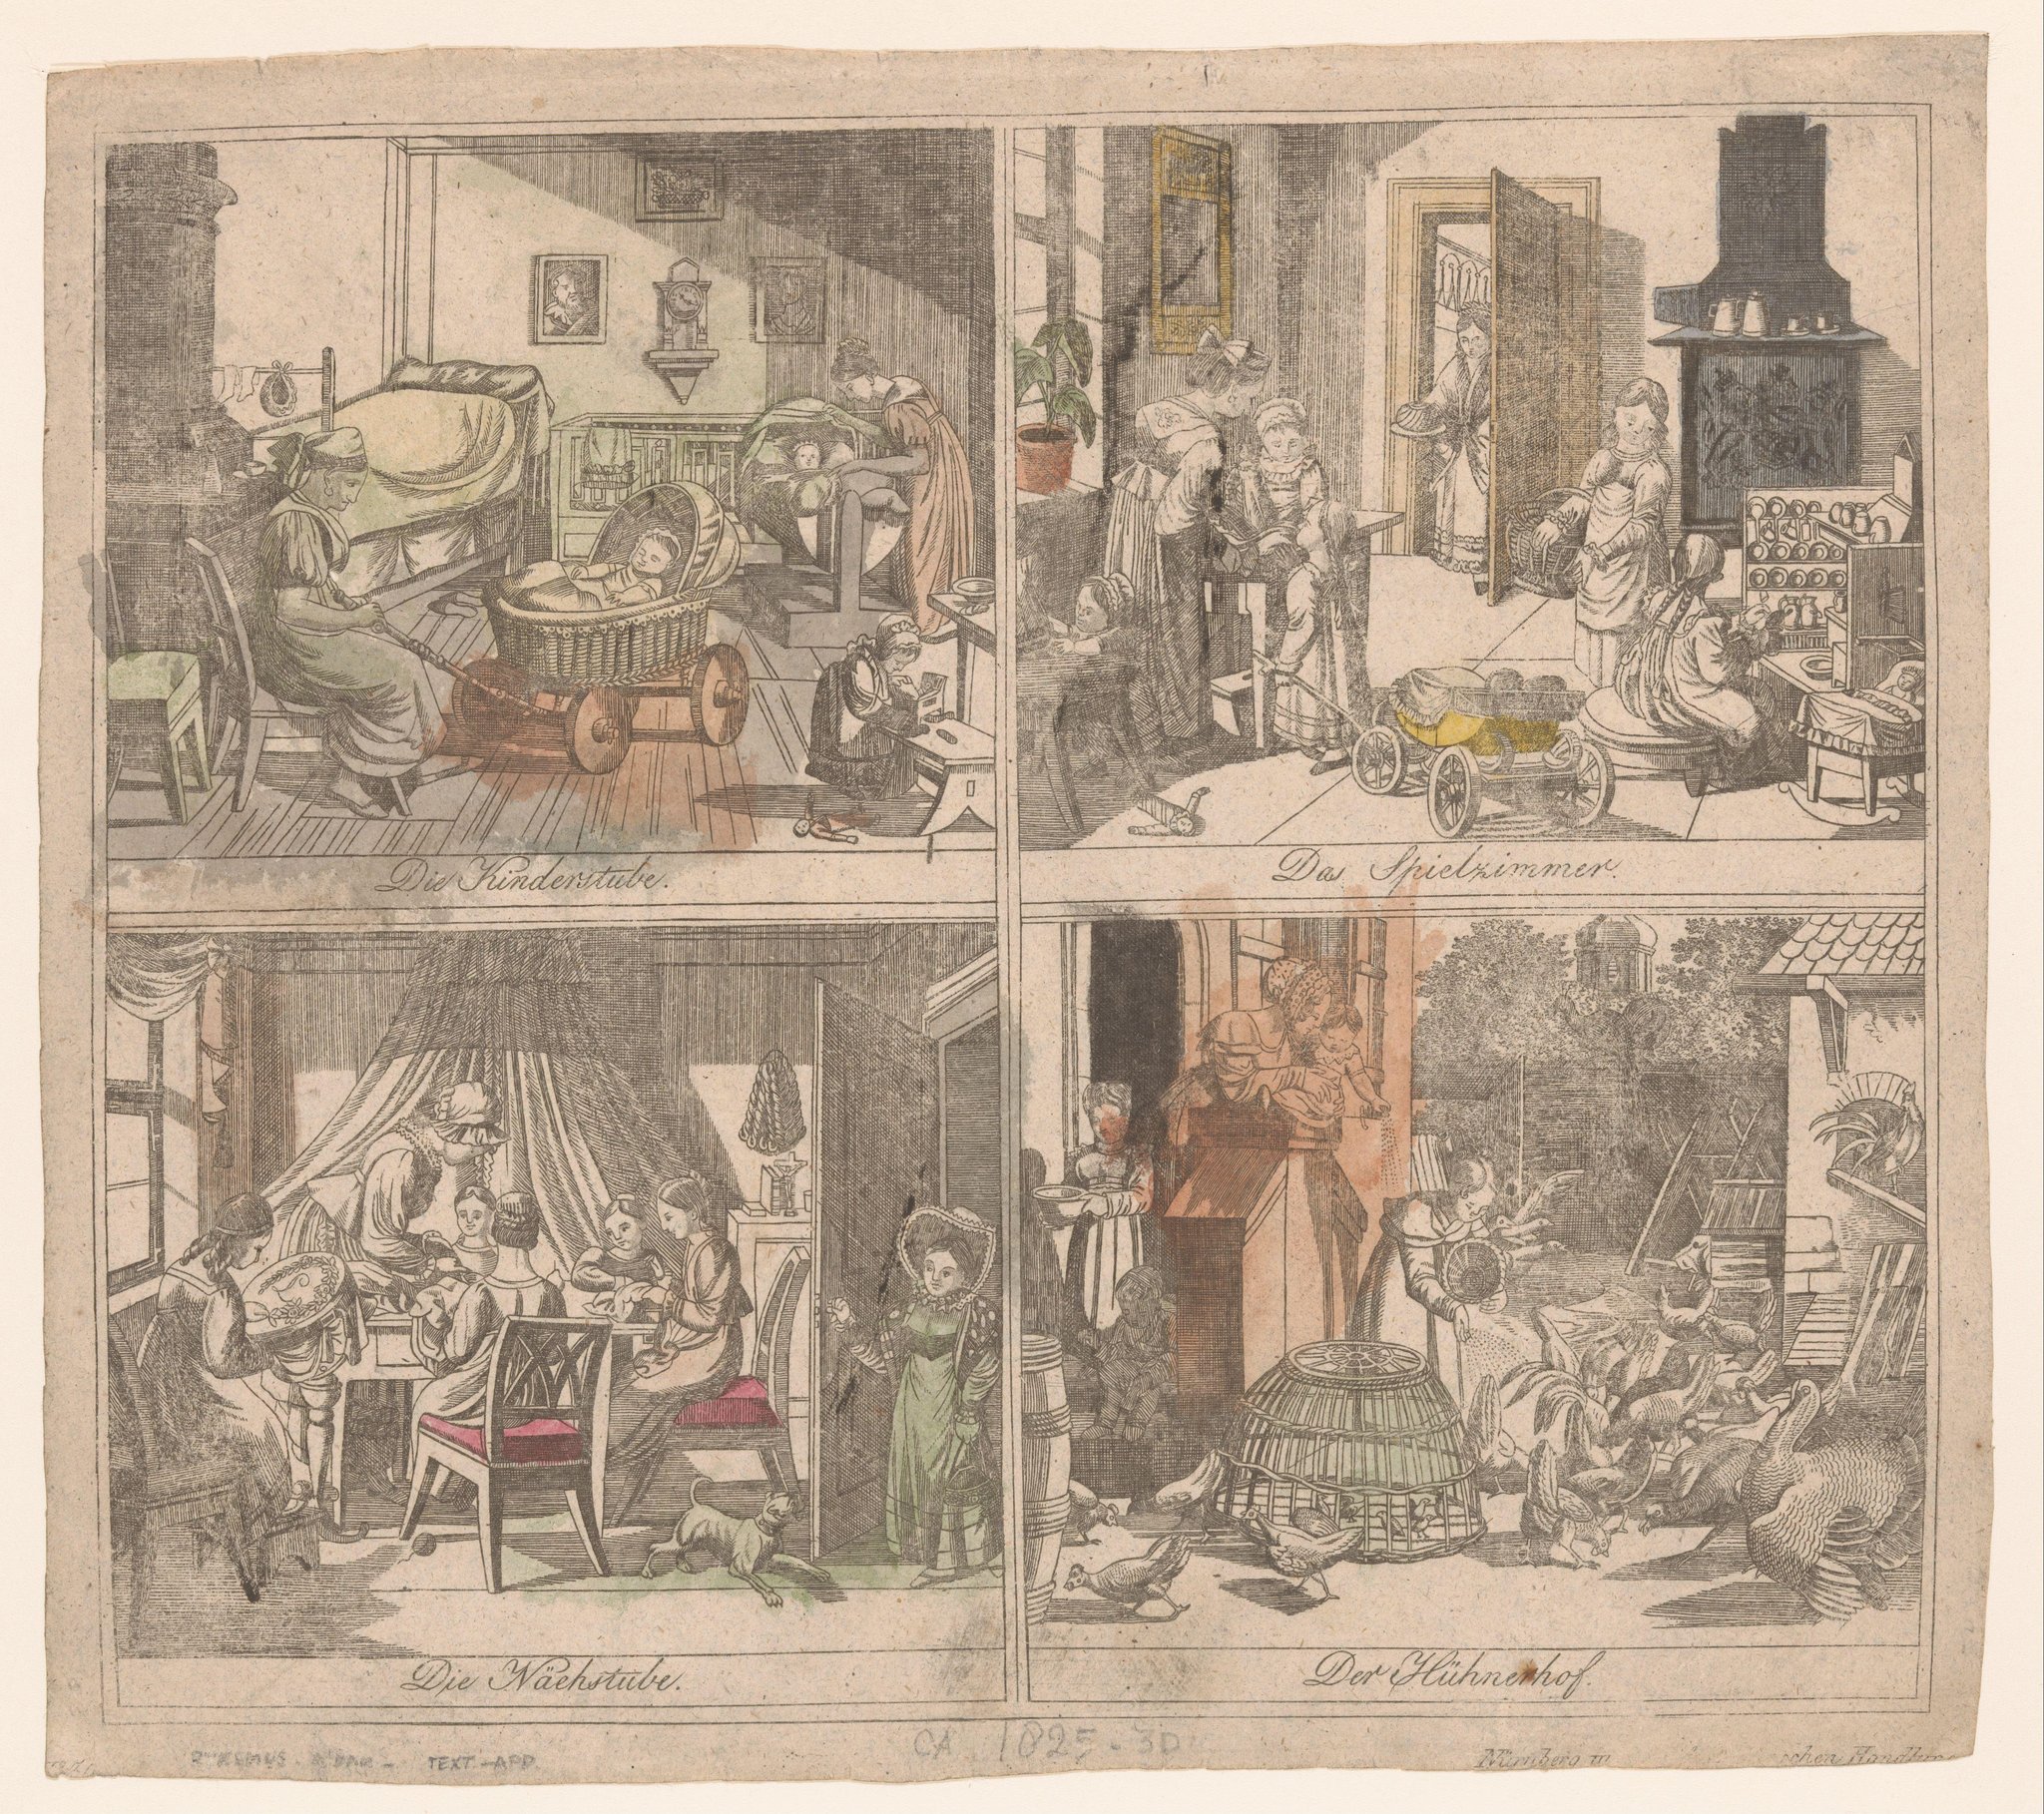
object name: print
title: Huiselijk leven van vrouwen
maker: Anonymous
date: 1800-1899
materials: paper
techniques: engraving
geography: nuremberg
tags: family life at home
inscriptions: collector's mark: Lugt 2228